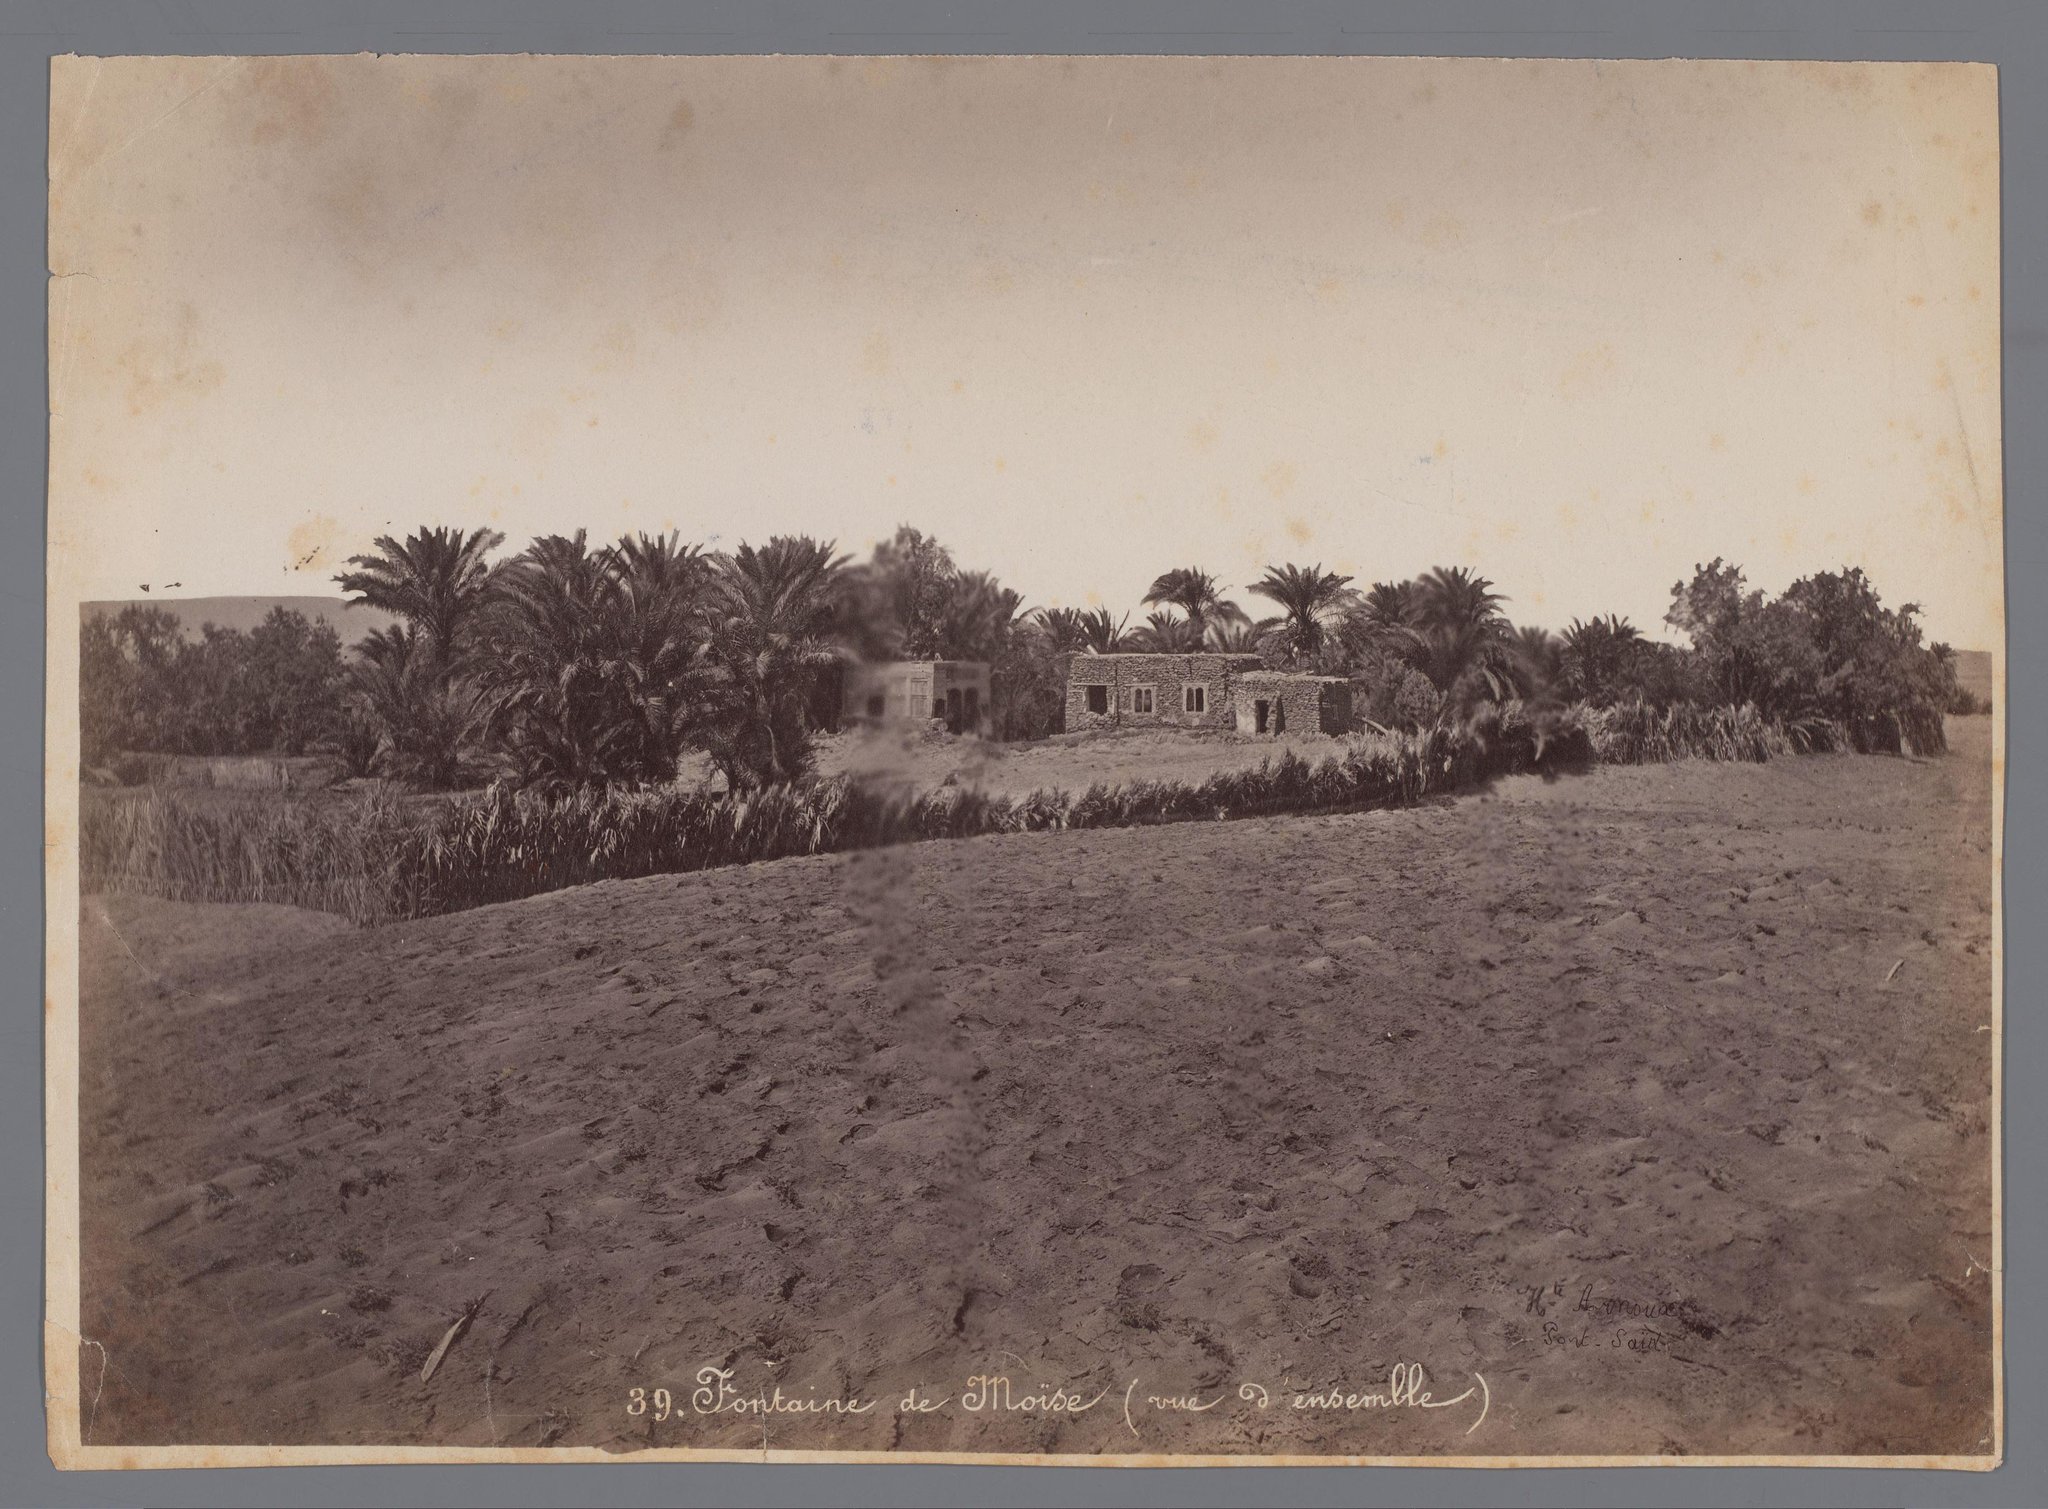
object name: photograph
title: Fontaine de Moïse (vue d'ensemble)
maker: Anonymous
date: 1860-1900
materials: paper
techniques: albumen print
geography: suez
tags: well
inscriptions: number: ‘39.’